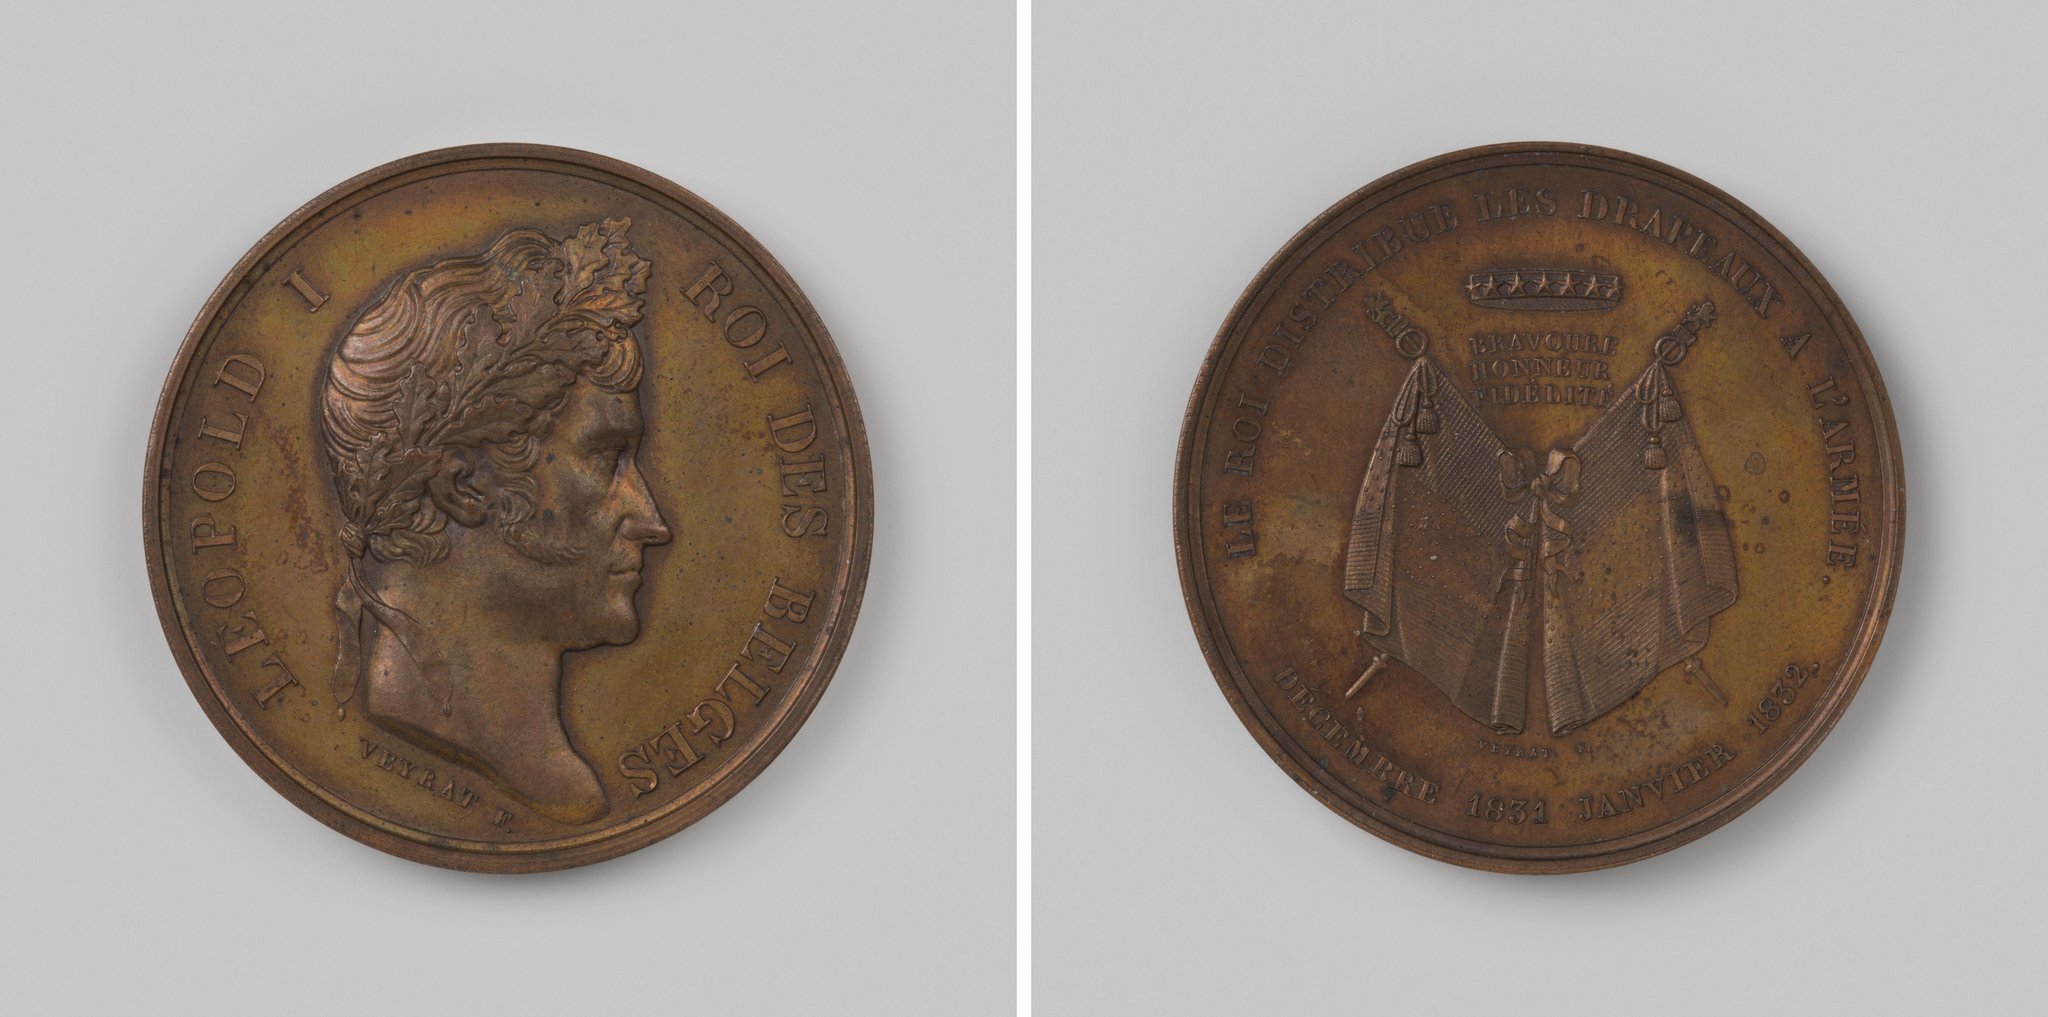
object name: history medal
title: Uitreiking van vaandels aan het leger te Brussel, Mechelen en Antwerpen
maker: adrien hippolyte veyrat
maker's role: medailleur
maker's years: 1803-1883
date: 1832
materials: bronze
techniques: striking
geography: brussels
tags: leopold i (koning der belgen), antwerp, mechelen, brussels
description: Bronzen penning. Voorzijde: borststuk man met eikekrans binnen omschrift. Keerzijde: twee gekruistevaandels onder opschrift en met sterren versierde kroon binnen omschrift